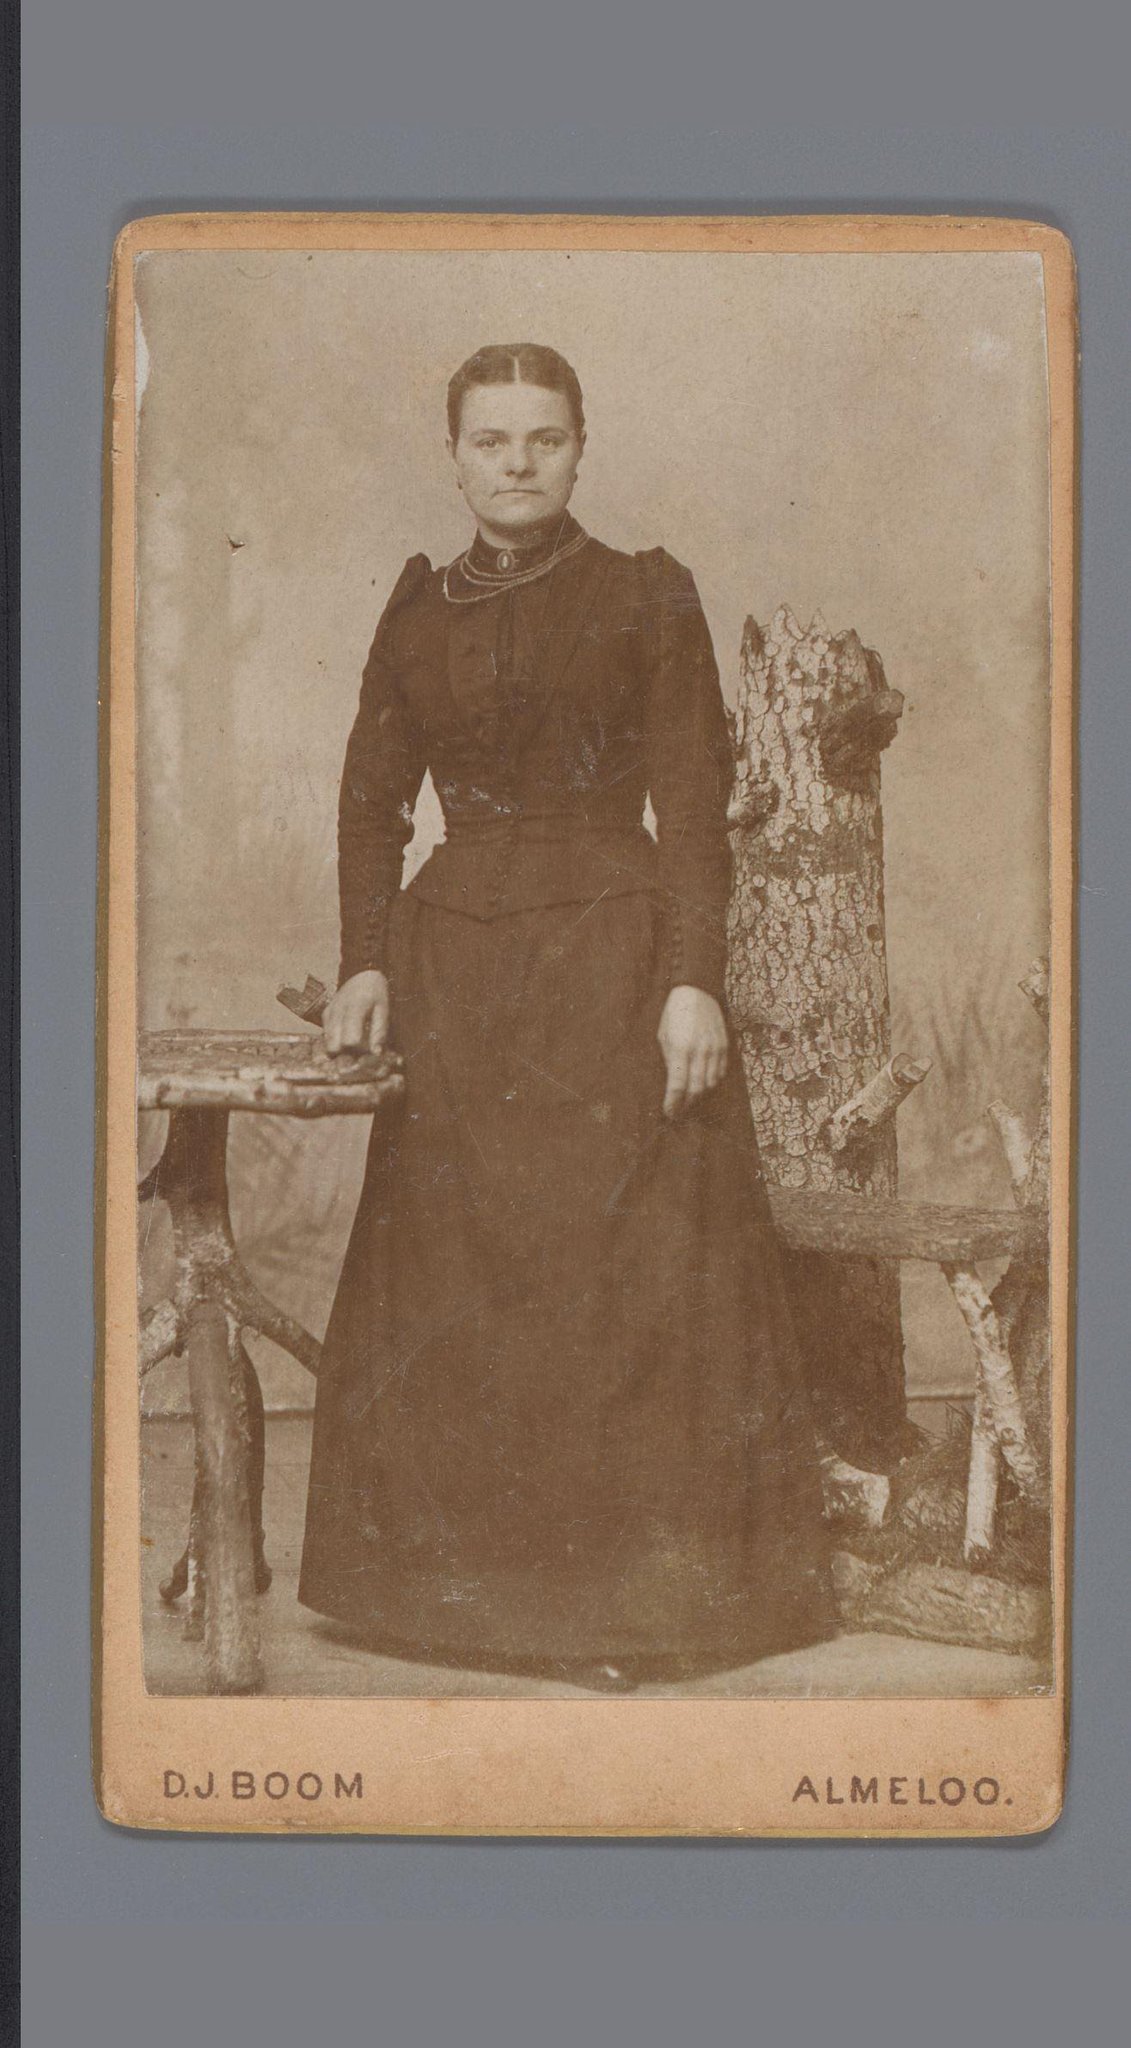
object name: carte de visite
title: Portret van een onbekende vrouw bij een tuintafel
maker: derk jan boom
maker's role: draughtsman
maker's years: 1853-1935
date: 1888-1912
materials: paper, cardboard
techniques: collodion silver print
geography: almelo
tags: adult woman, anonymous historical person portrayed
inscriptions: name: ‘Loman & Co Amsterdam.’, inscription: ‘Photograaf/ en/ Portretteekenaar/ Van ieder portret kunnen artistieke/ vergrootingen geleverd worden.’